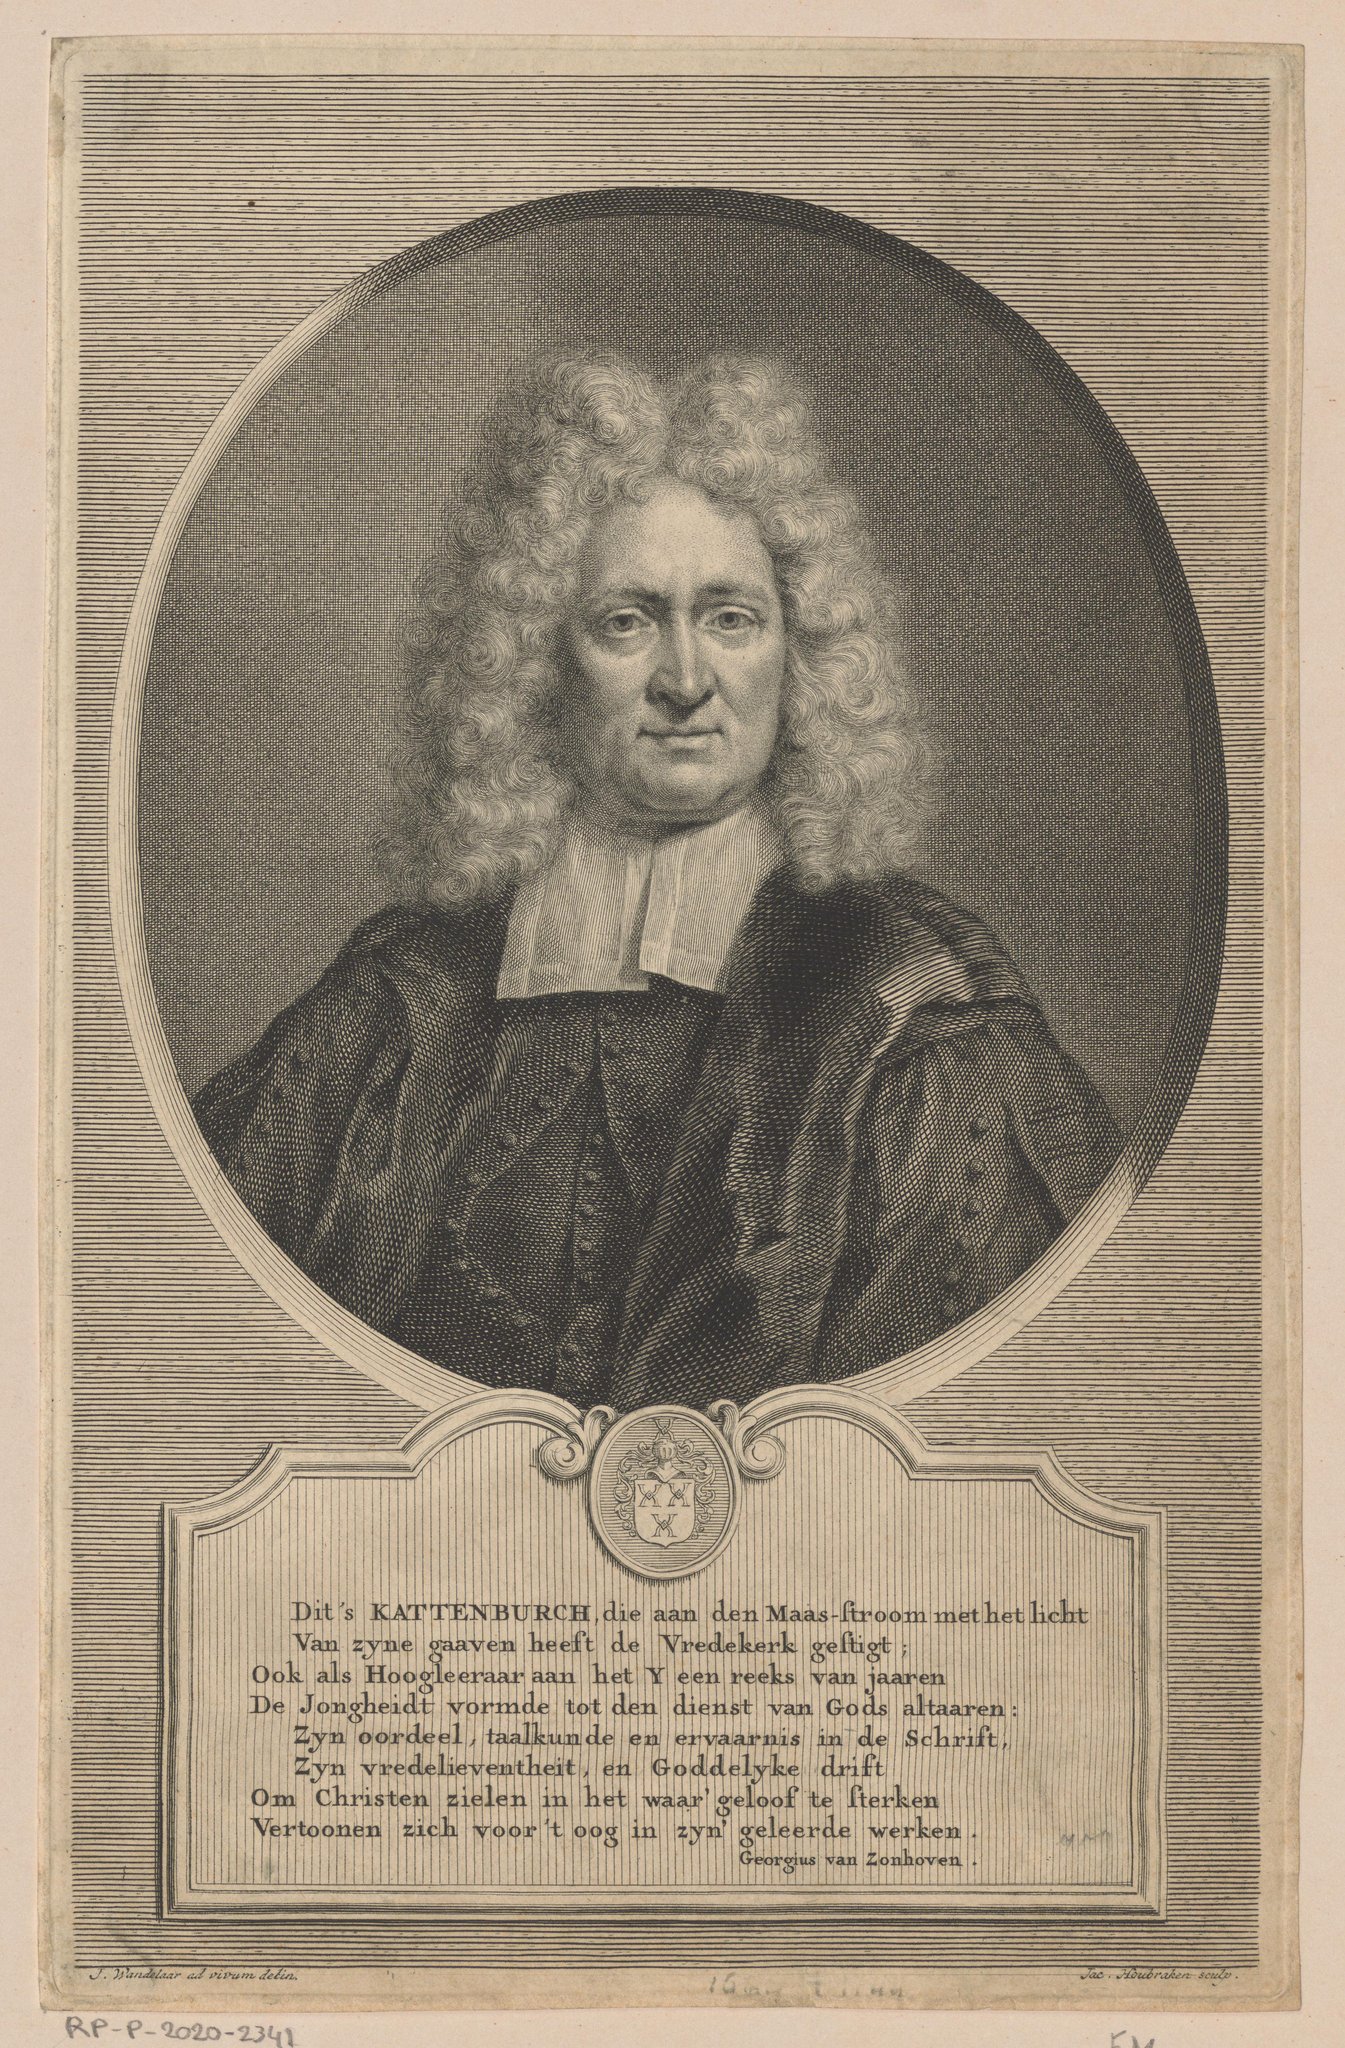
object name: print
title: Portret van Adriaan van Cattenburgh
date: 1725-1780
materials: paper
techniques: engraving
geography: amsterdam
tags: rotterdam, adriaan van cattenburgh, historical persons